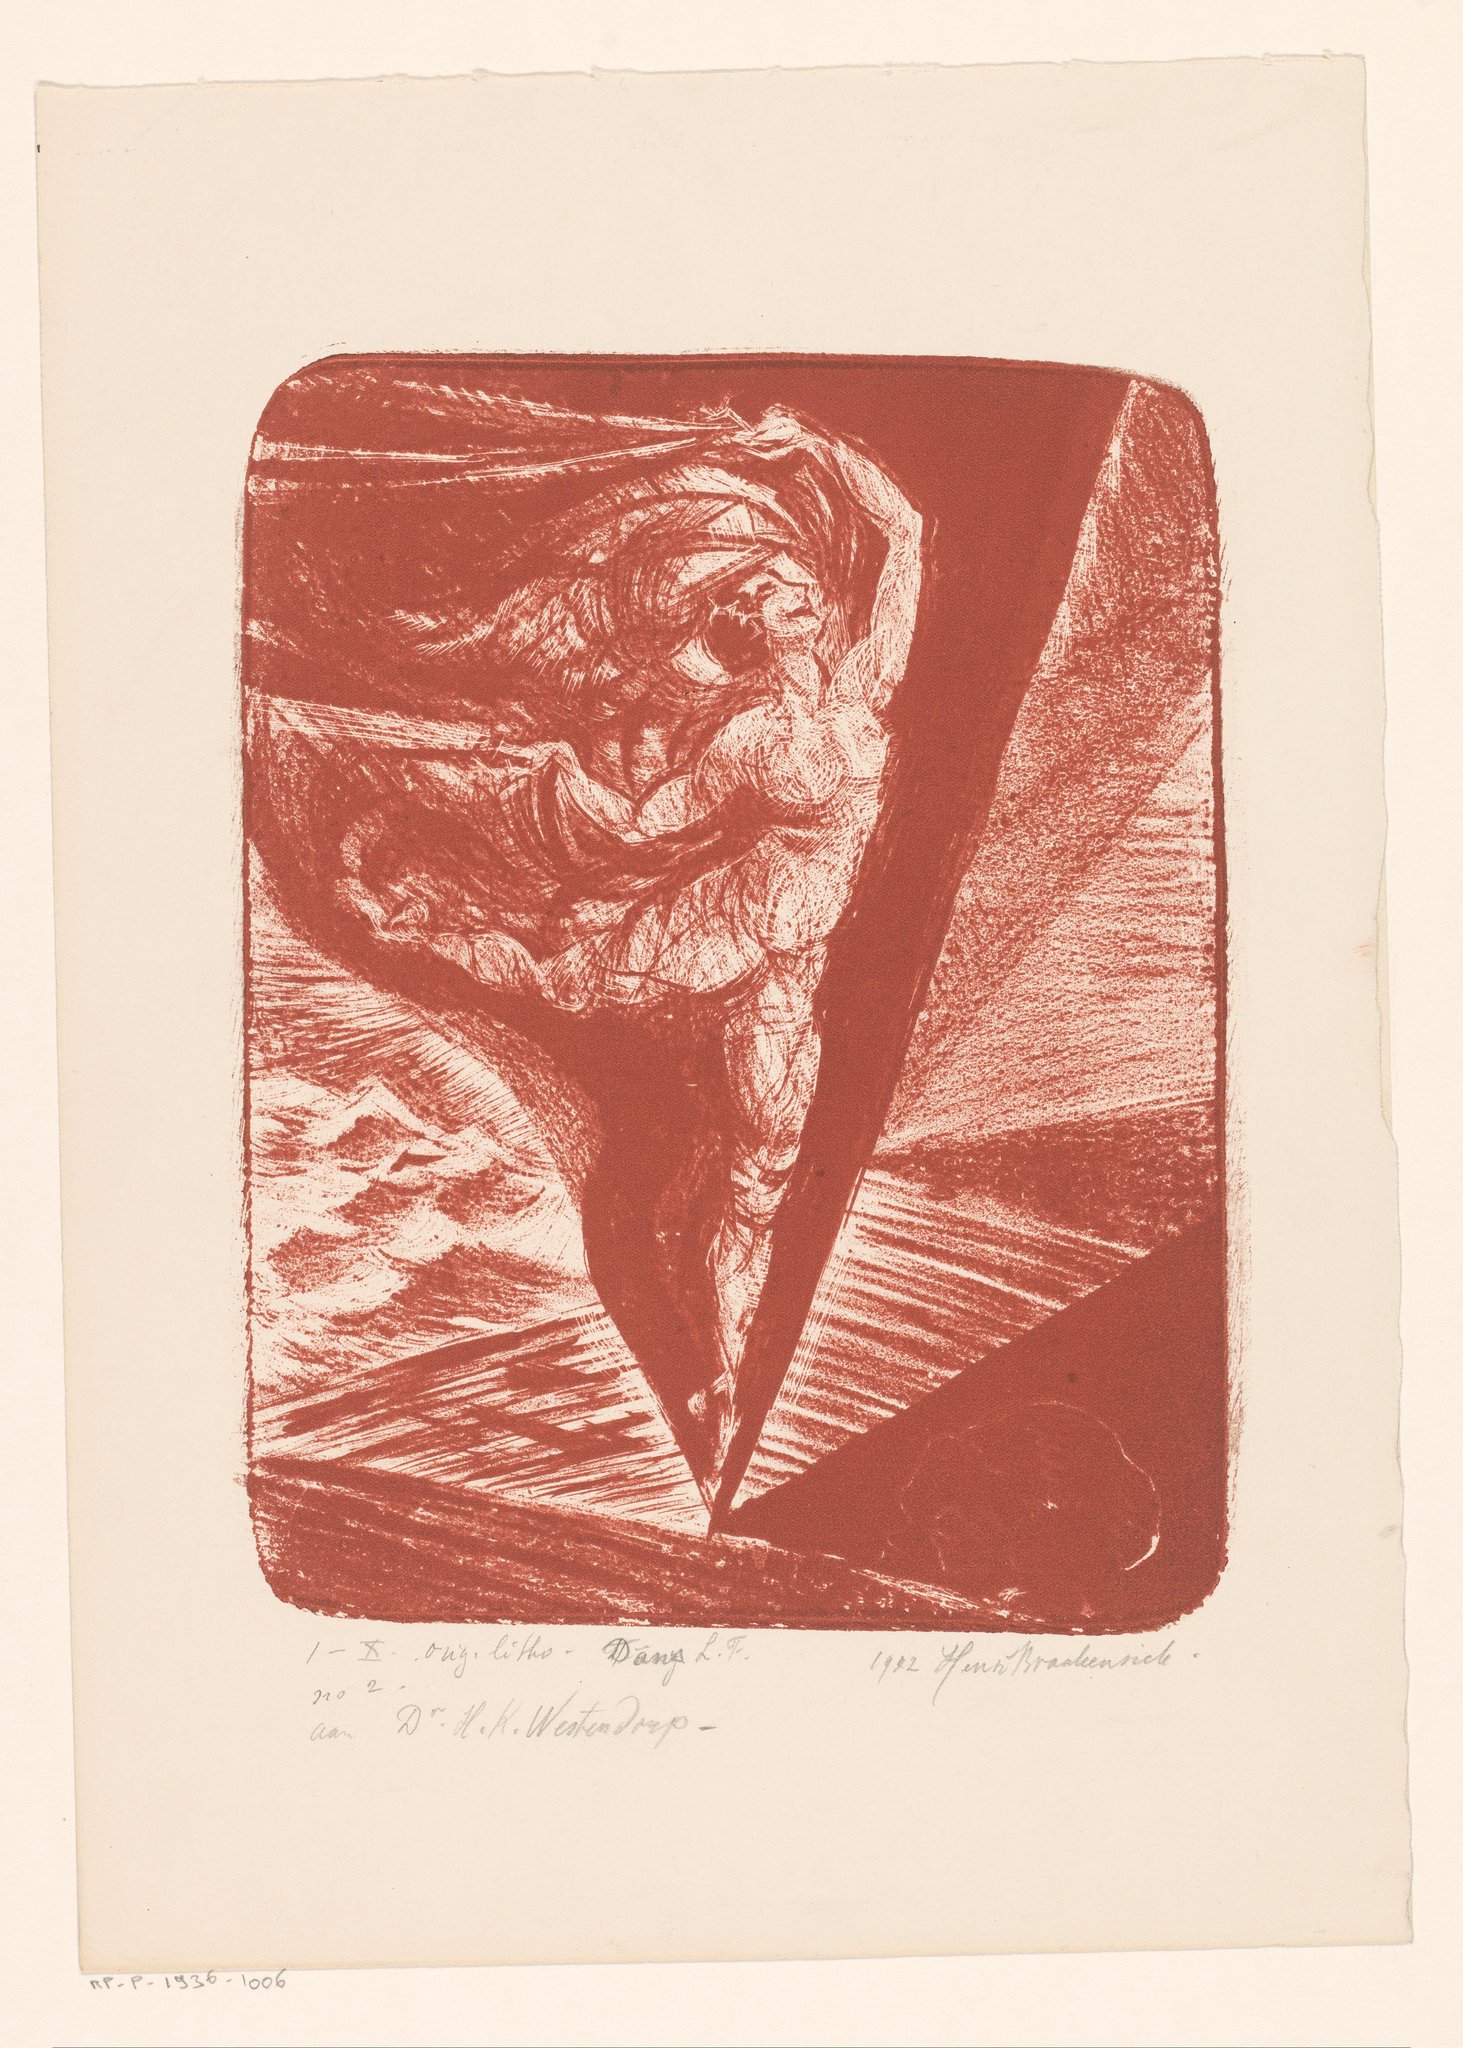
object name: print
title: Dans L.F.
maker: henri braakensiek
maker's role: print maker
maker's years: 1891-1941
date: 1922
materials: paper, ink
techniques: lithograph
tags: woman dancing alone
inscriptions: collector's mark: Lugt 2228, signature and date: ‘1922 Henri Braakensiek.’, title: ‘Dans L.F.’, dedication: ‘aan Dr. H.K. Westendorp.’, edition: ‘I-X orig. litho no 2’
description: Dansende naakte vrouw zwevend boven een landschap in een driehoekige vorm.